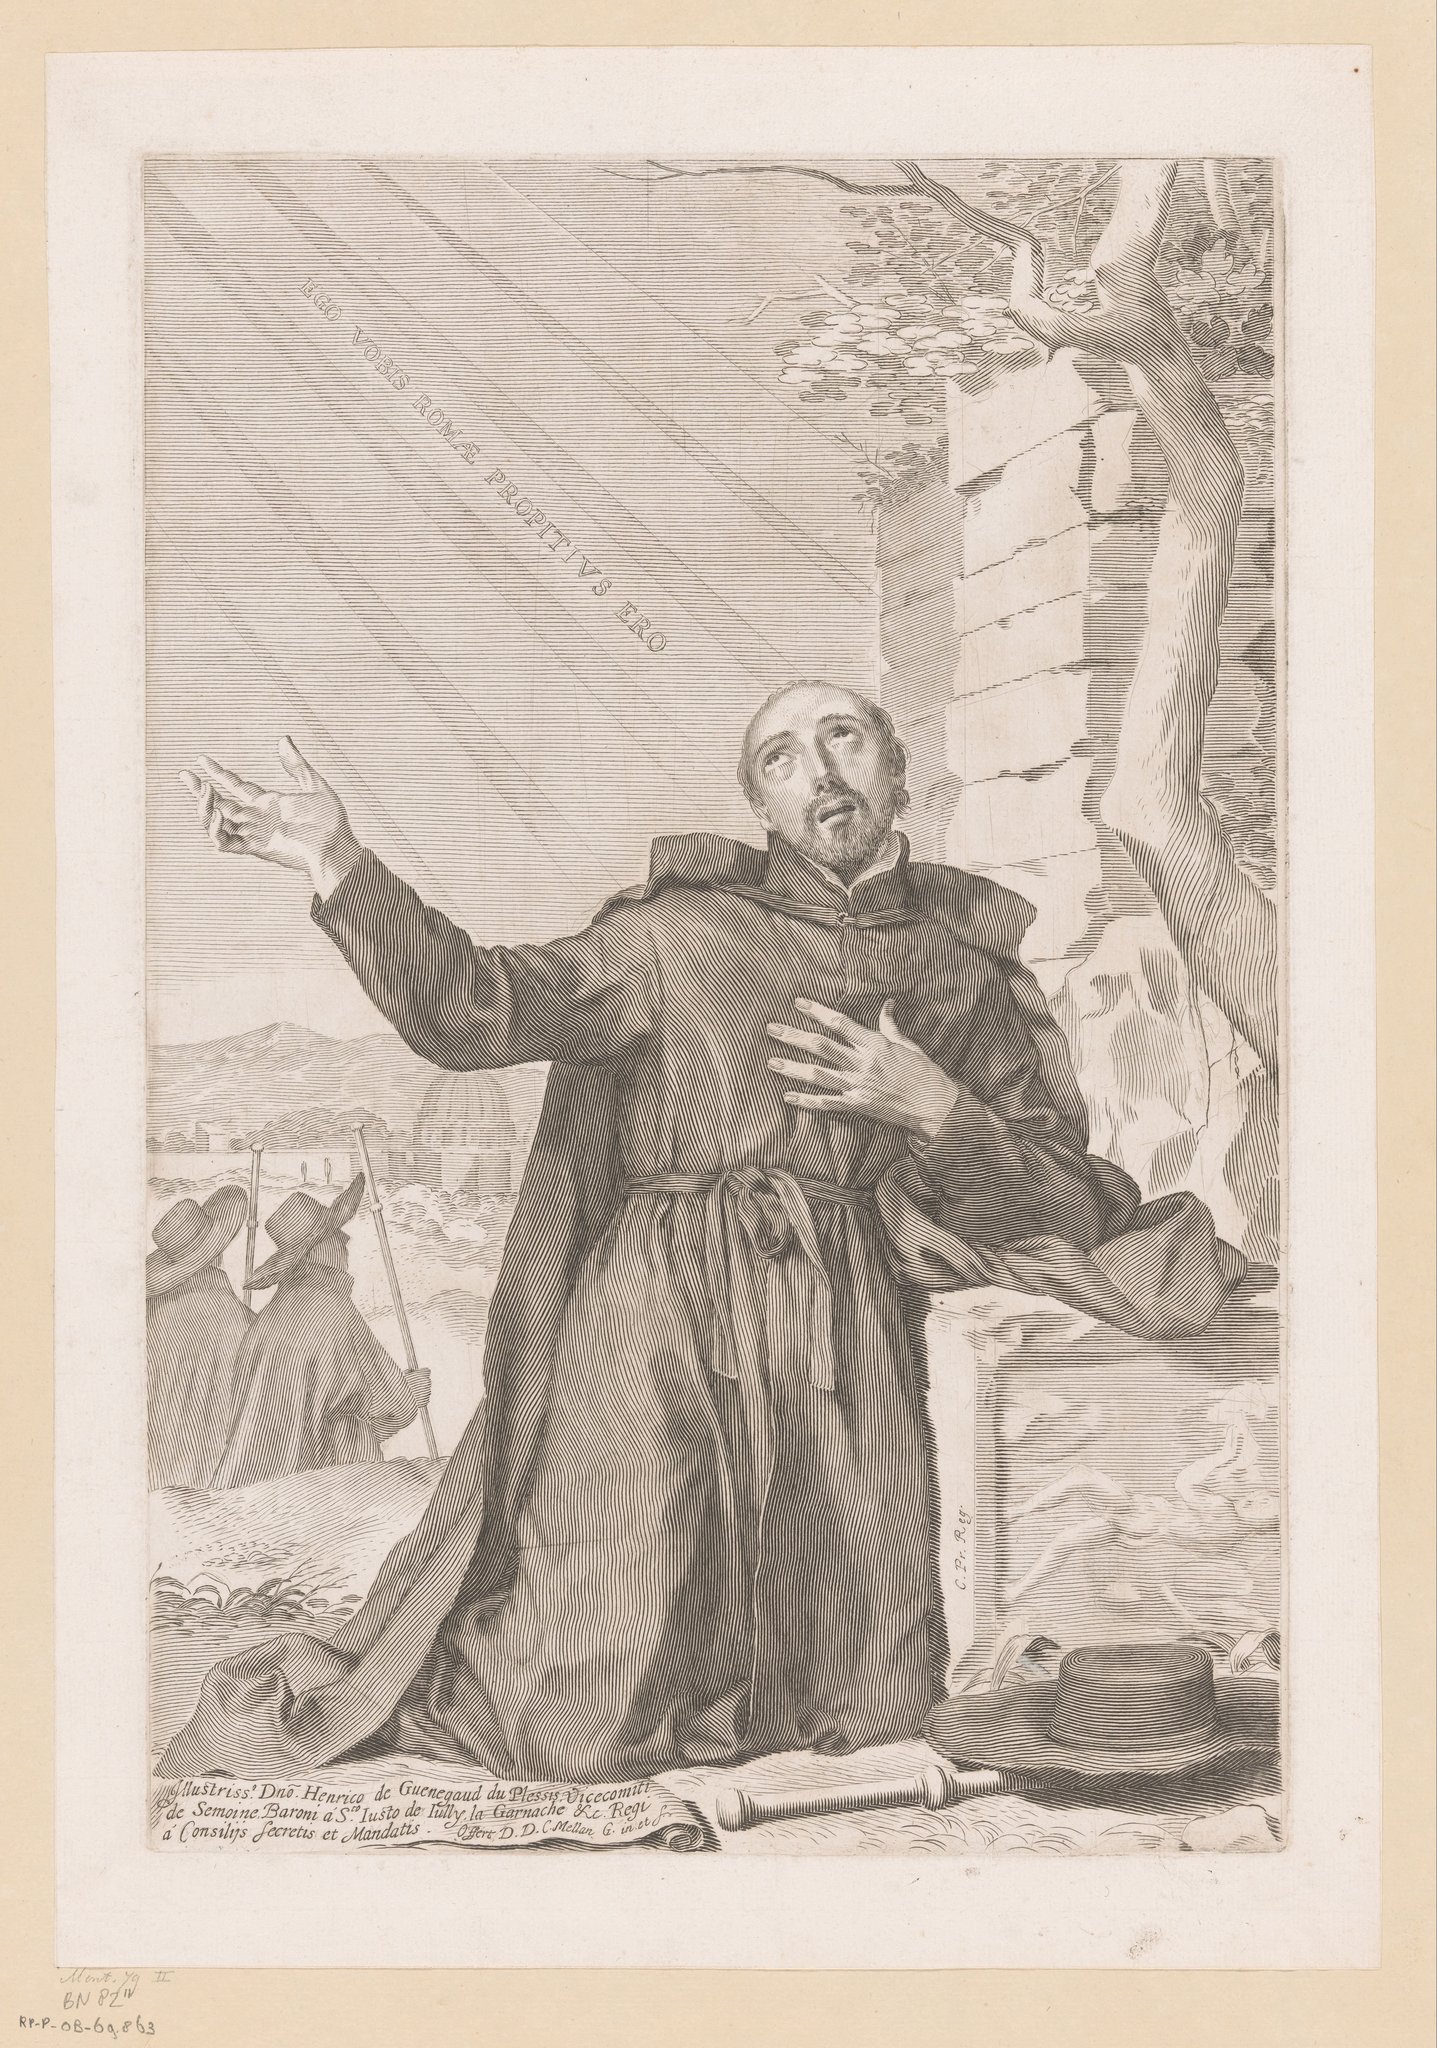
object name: print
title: H. Ignatius van Loyola in extase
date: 1608-1676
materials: paper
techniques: engraving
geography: france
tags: pilgrimage, pilgrim(s) under way, visions of st. ignatius of loyola, rome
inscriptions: collector's mark: Lugt 240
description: De heilige Ignatius van Loyola, knielend in extase voor een blok met reliëf. Op de achtergrond links lopen pelgrims naar Rome.